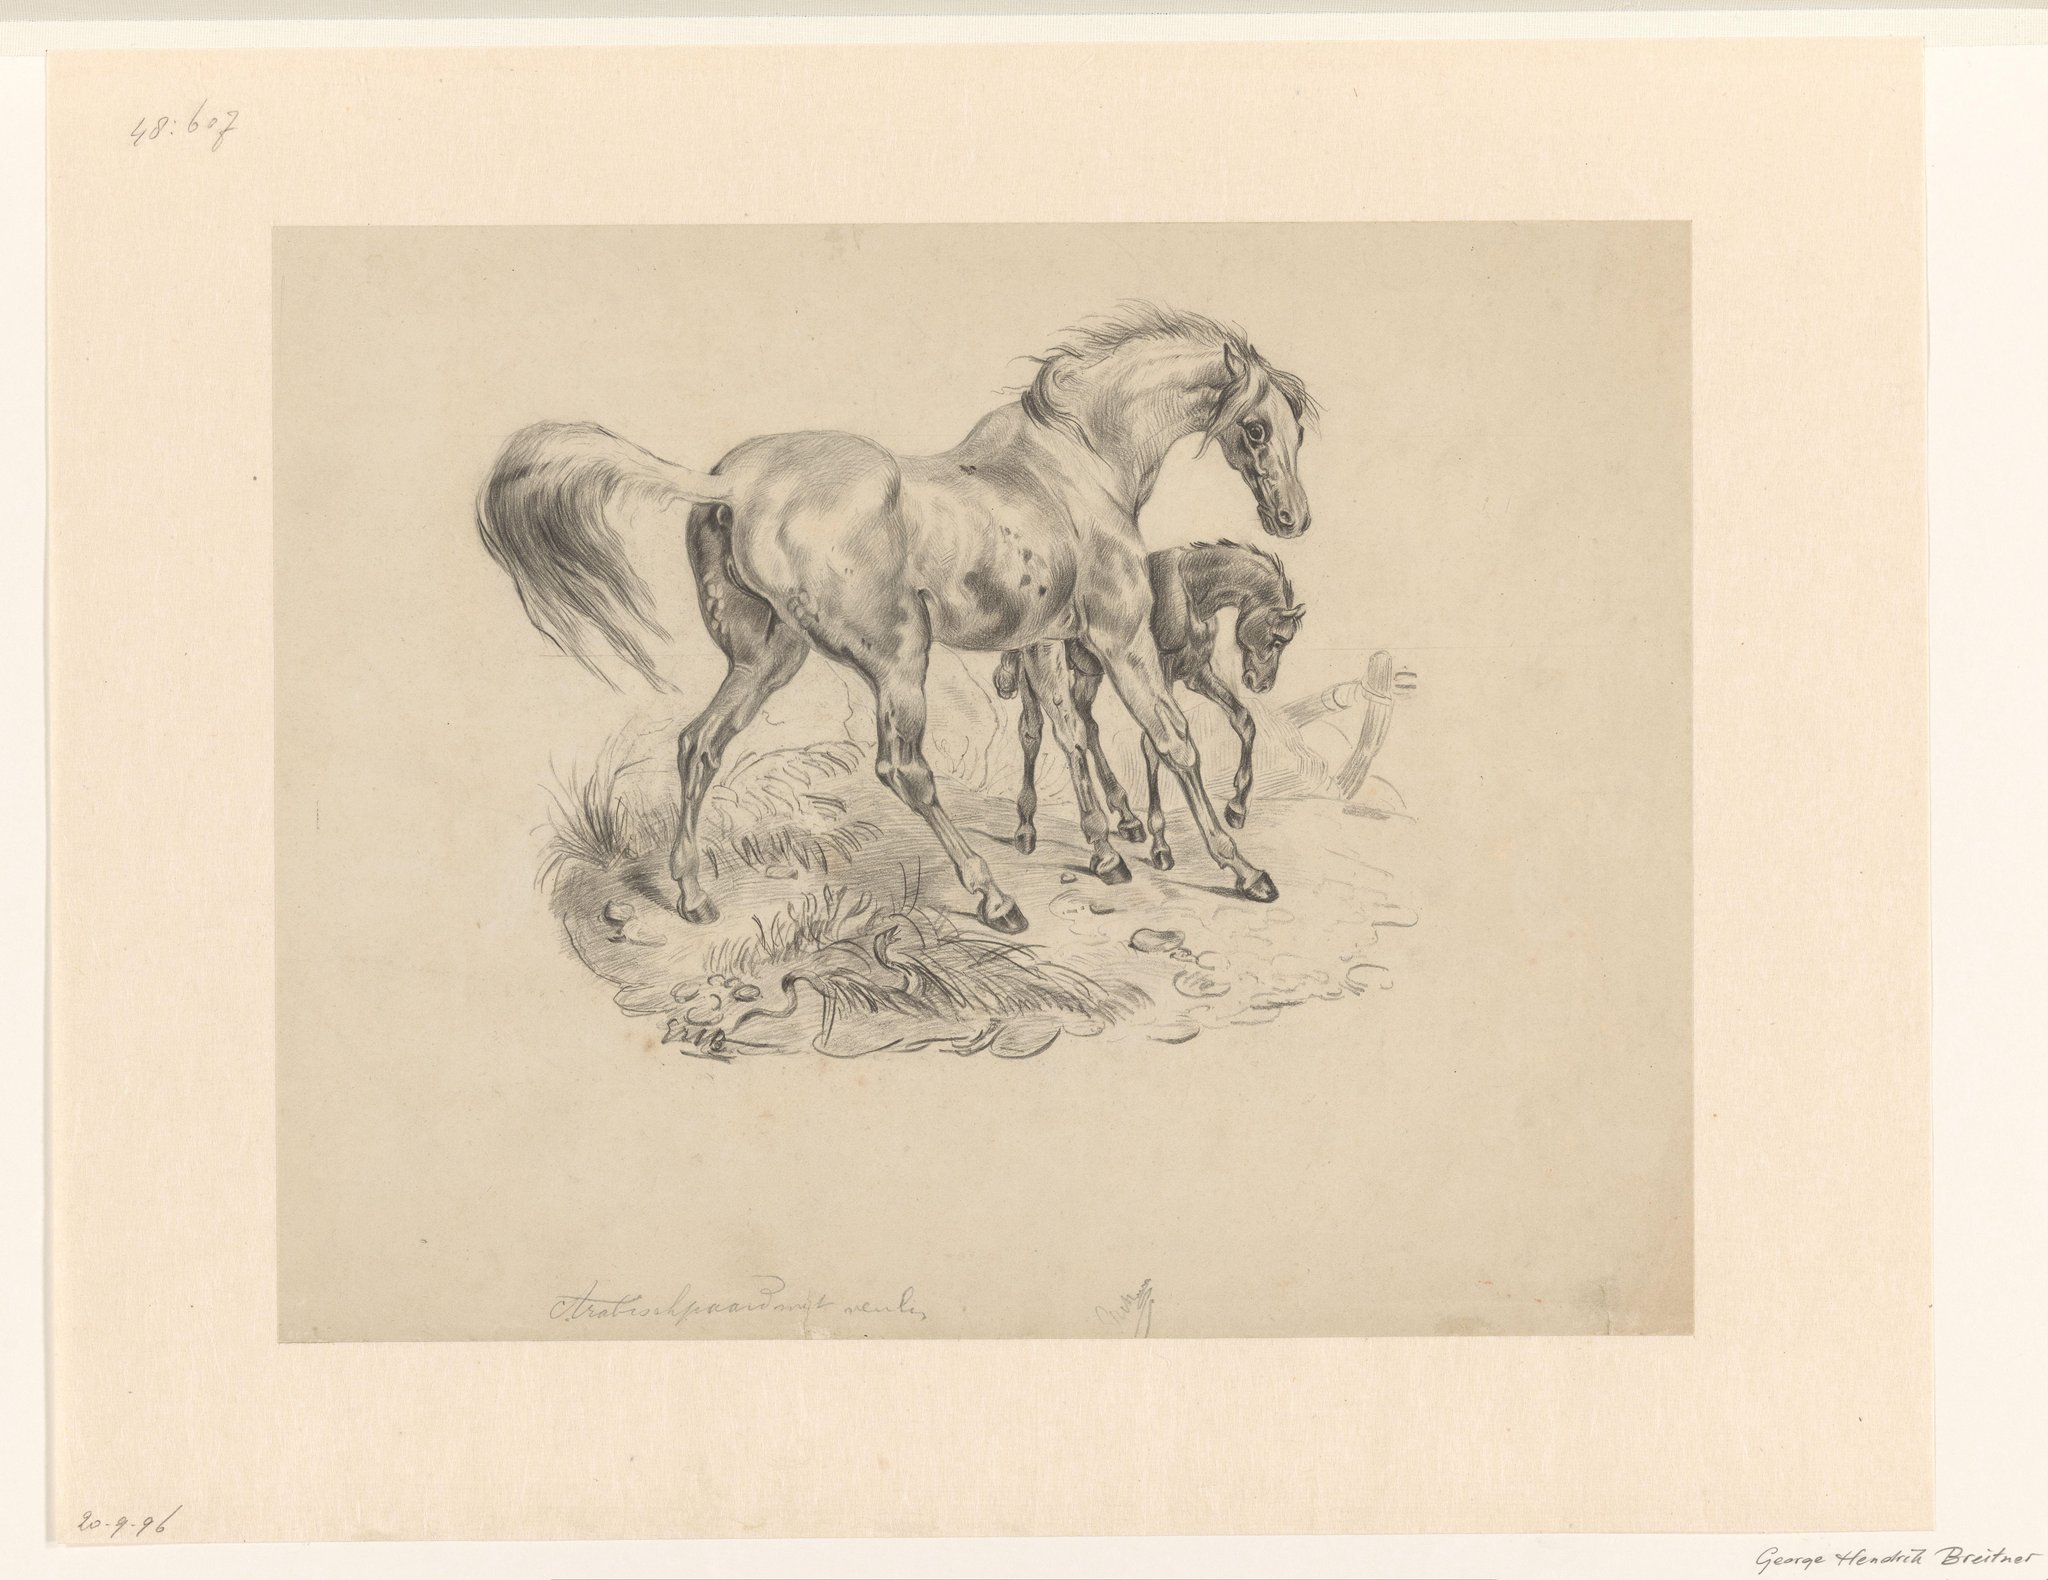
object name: drawing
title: Arabisch paard met veulen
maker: george hendrik breitner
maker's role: draughtsman, painter, print maker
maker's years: 1857-1923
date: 1867-1923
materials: chalk, paper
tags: horse